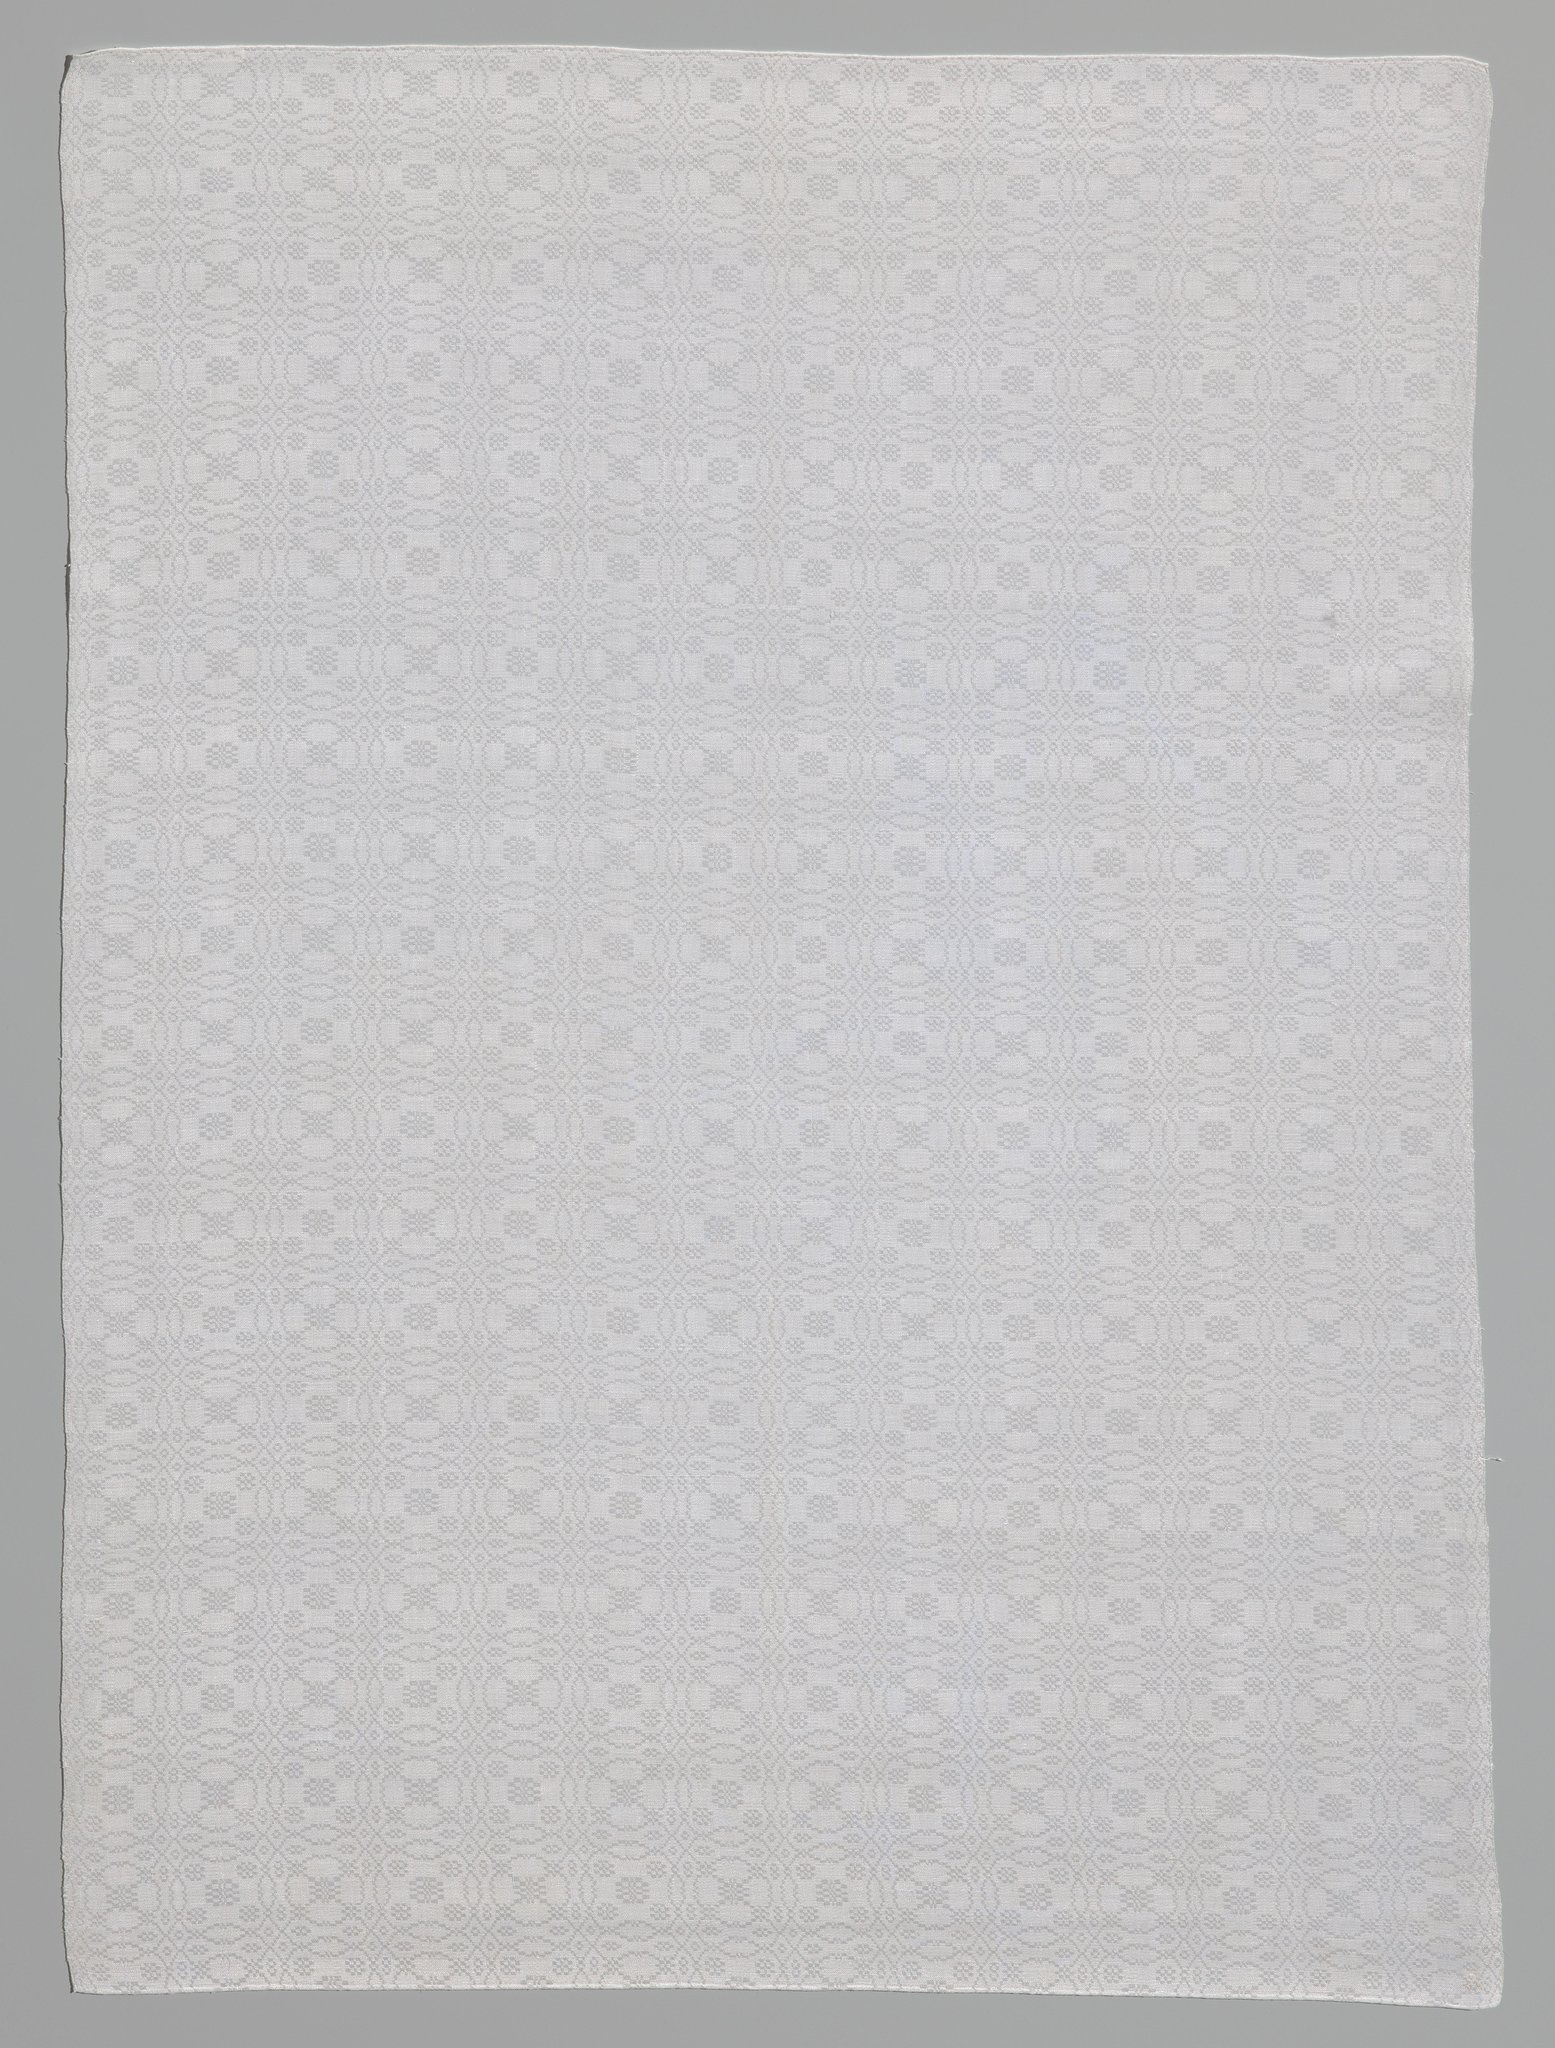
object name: napkin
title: Servet van linnen met pellenpatroon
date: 1675-1700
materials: linen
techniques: peeled fabric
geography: northern netherlands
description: wit linnen servet met pellen patroon, merk HW 32